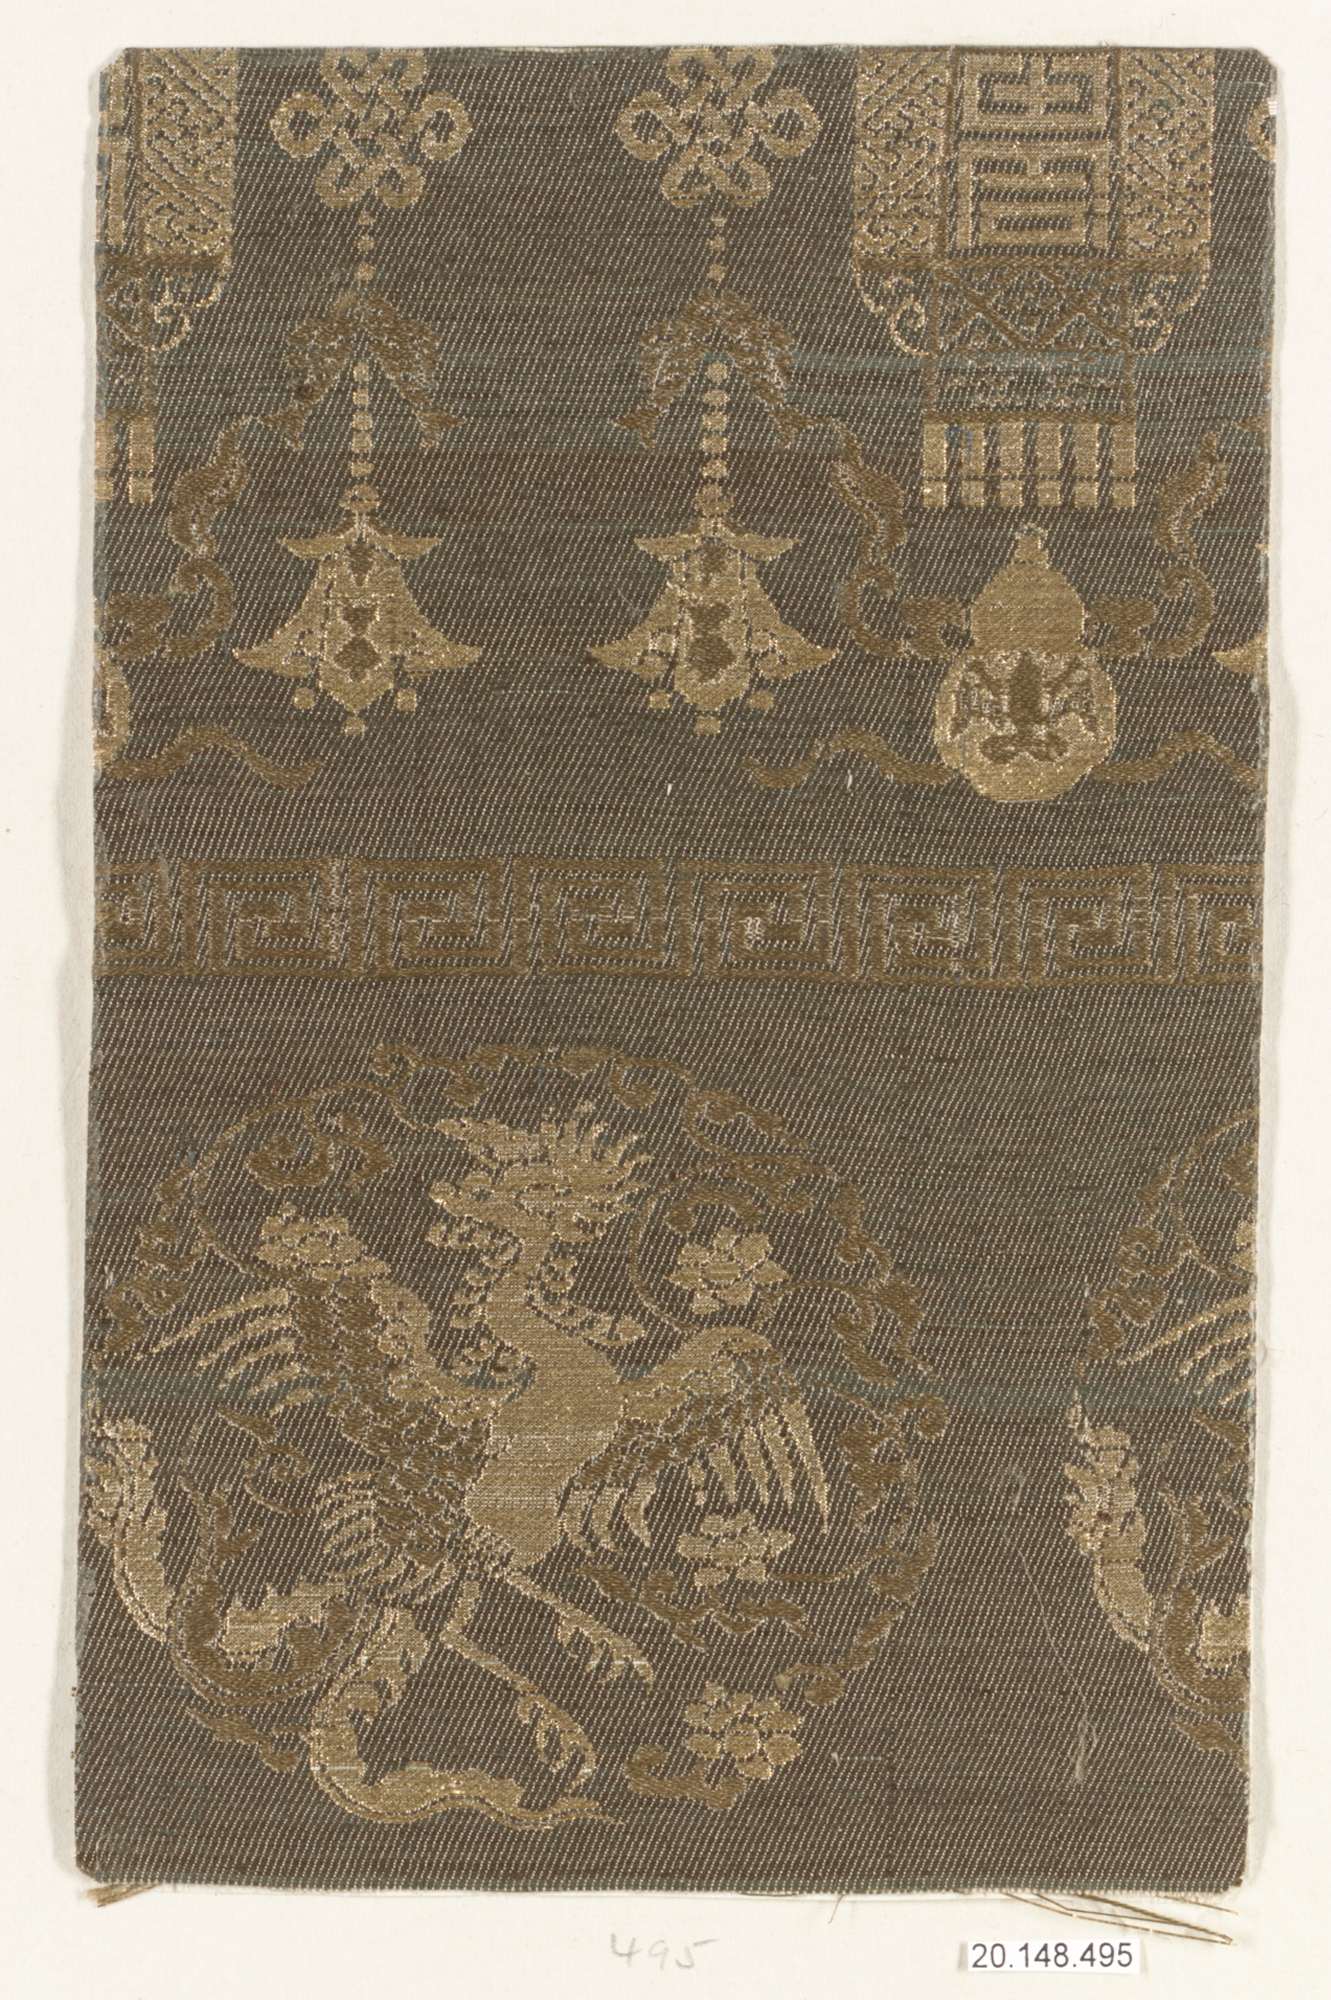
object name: piece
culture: chinese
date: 1701-1800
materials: silk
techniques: compound weave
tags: mythical creatures